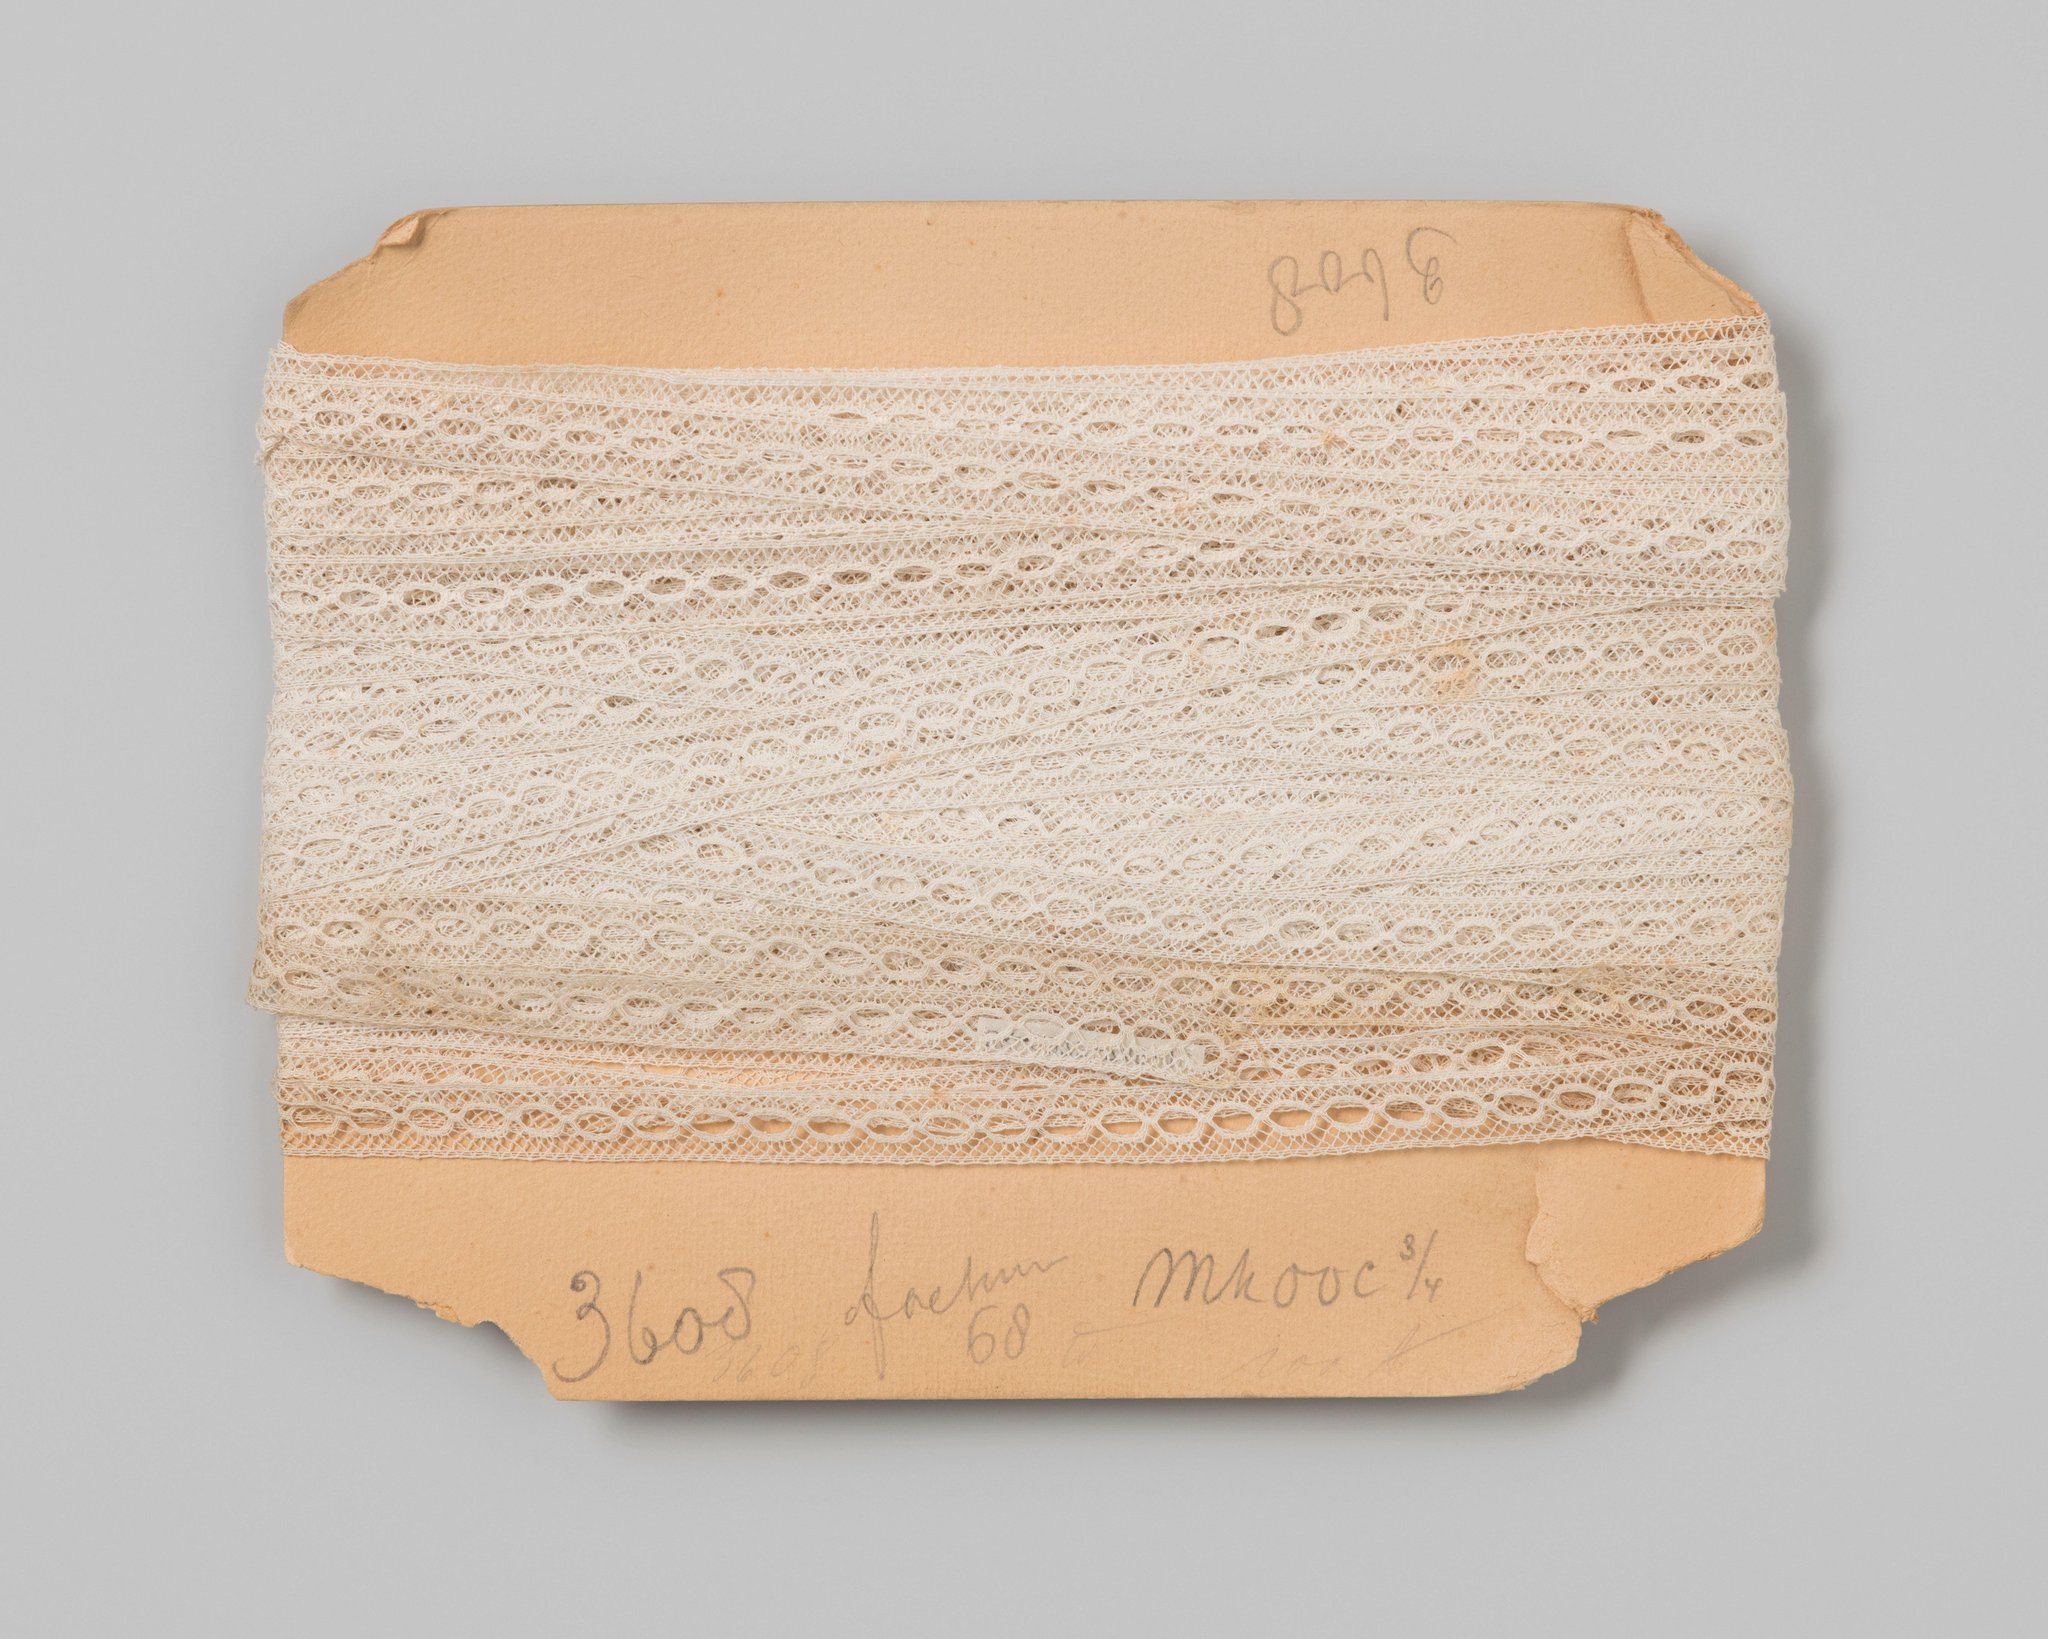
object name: entre deux, tussenzetsel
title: Tussenzetsel van wit kant gedecoreerd met aaneengeregen opengewerkte ovalen op karton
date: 1920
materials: cardboard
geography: nijmegen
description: Tussenzetsel van wit kant gedecoreerd met aaneengeregen opengewerkte ovalen op karton.